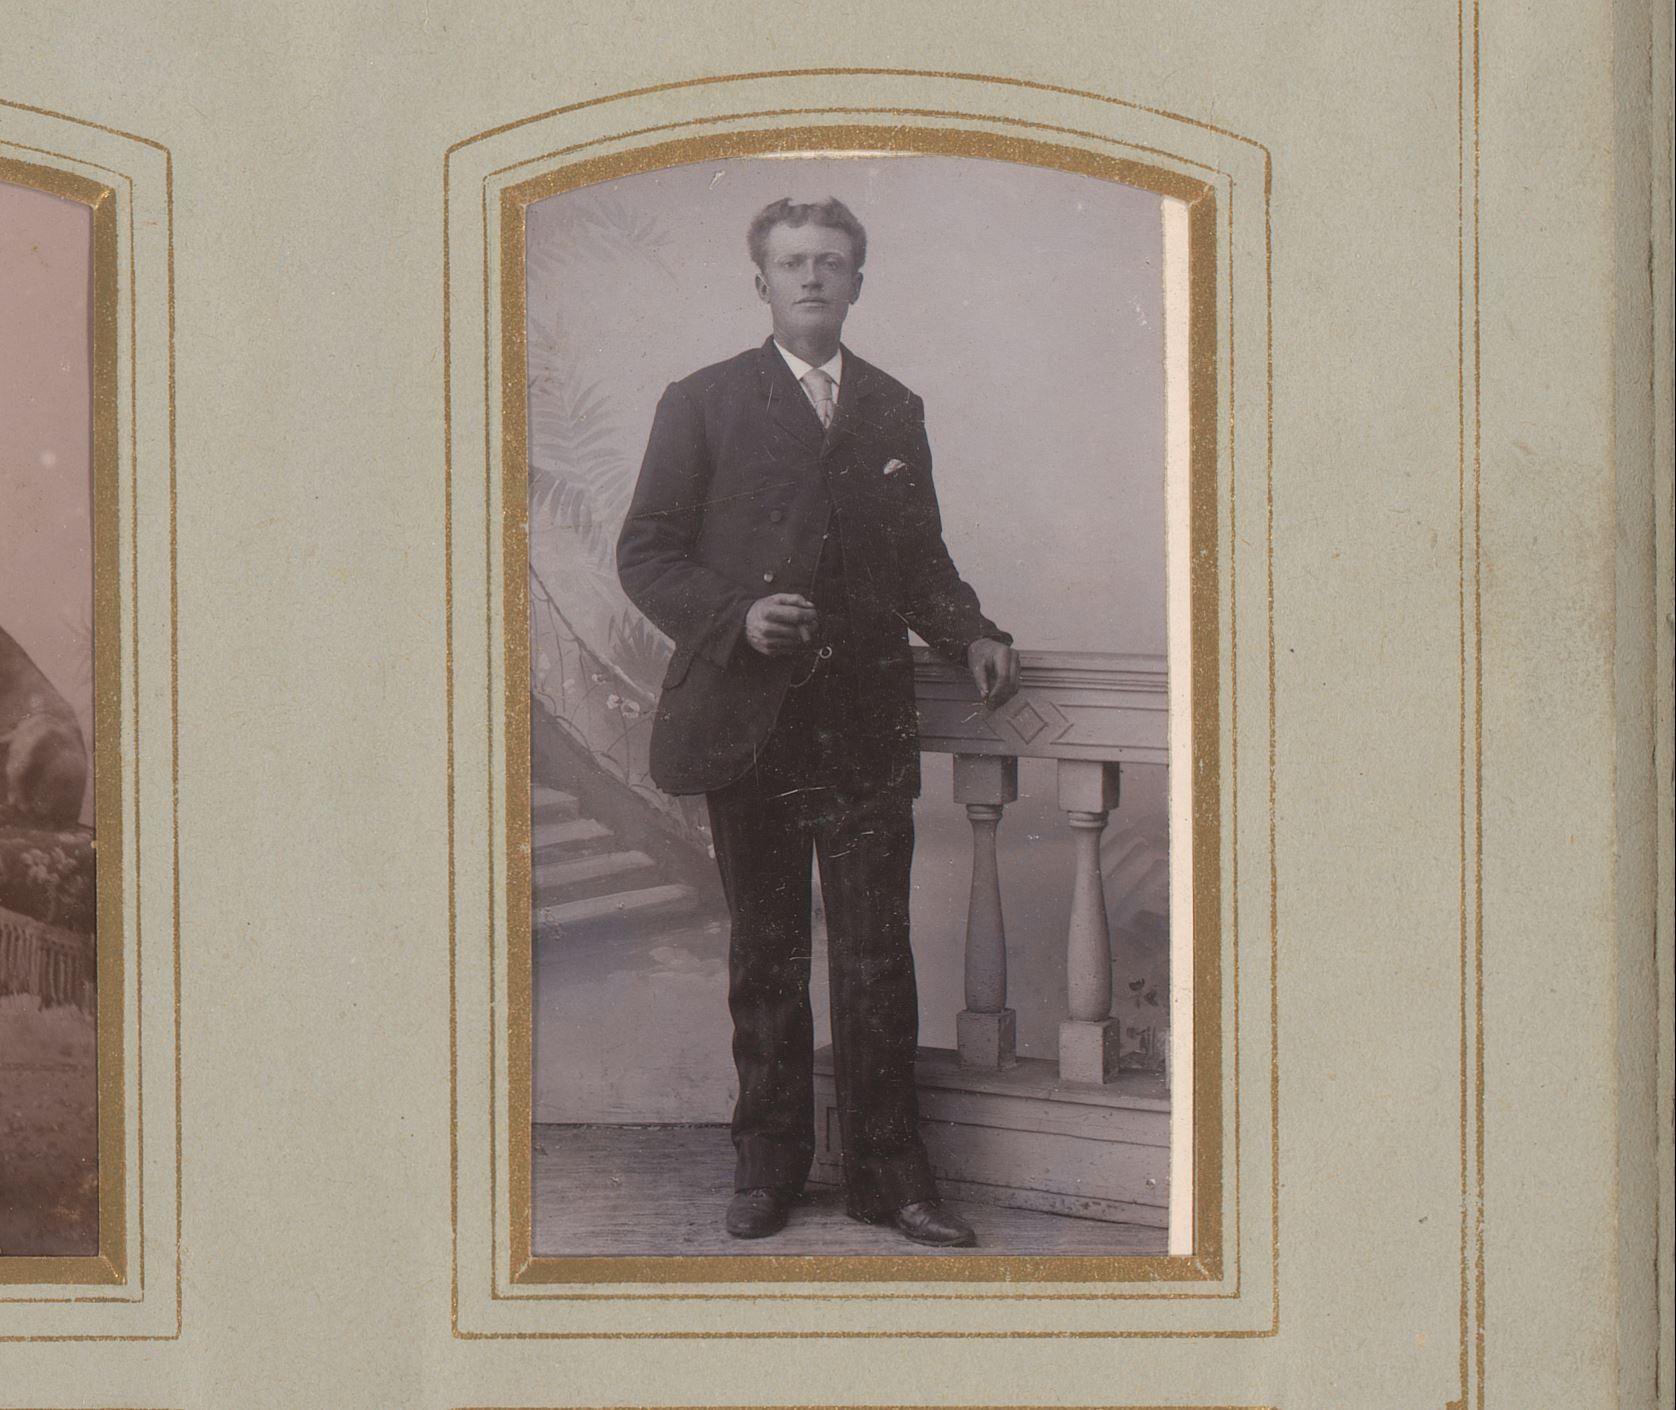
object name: photograph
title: Portret van een man, staand bij een balustrade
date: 1865-1874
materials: cardboard, photographic support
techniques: collodion silver print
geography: hilversum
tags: historical persons, balustrade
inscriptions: inscription: ‘Gebrs IJPMA./ FOTOGRAFEN./ EDAM/ VOORHAVEN./ WORMERVEER/ WANDELWEG’